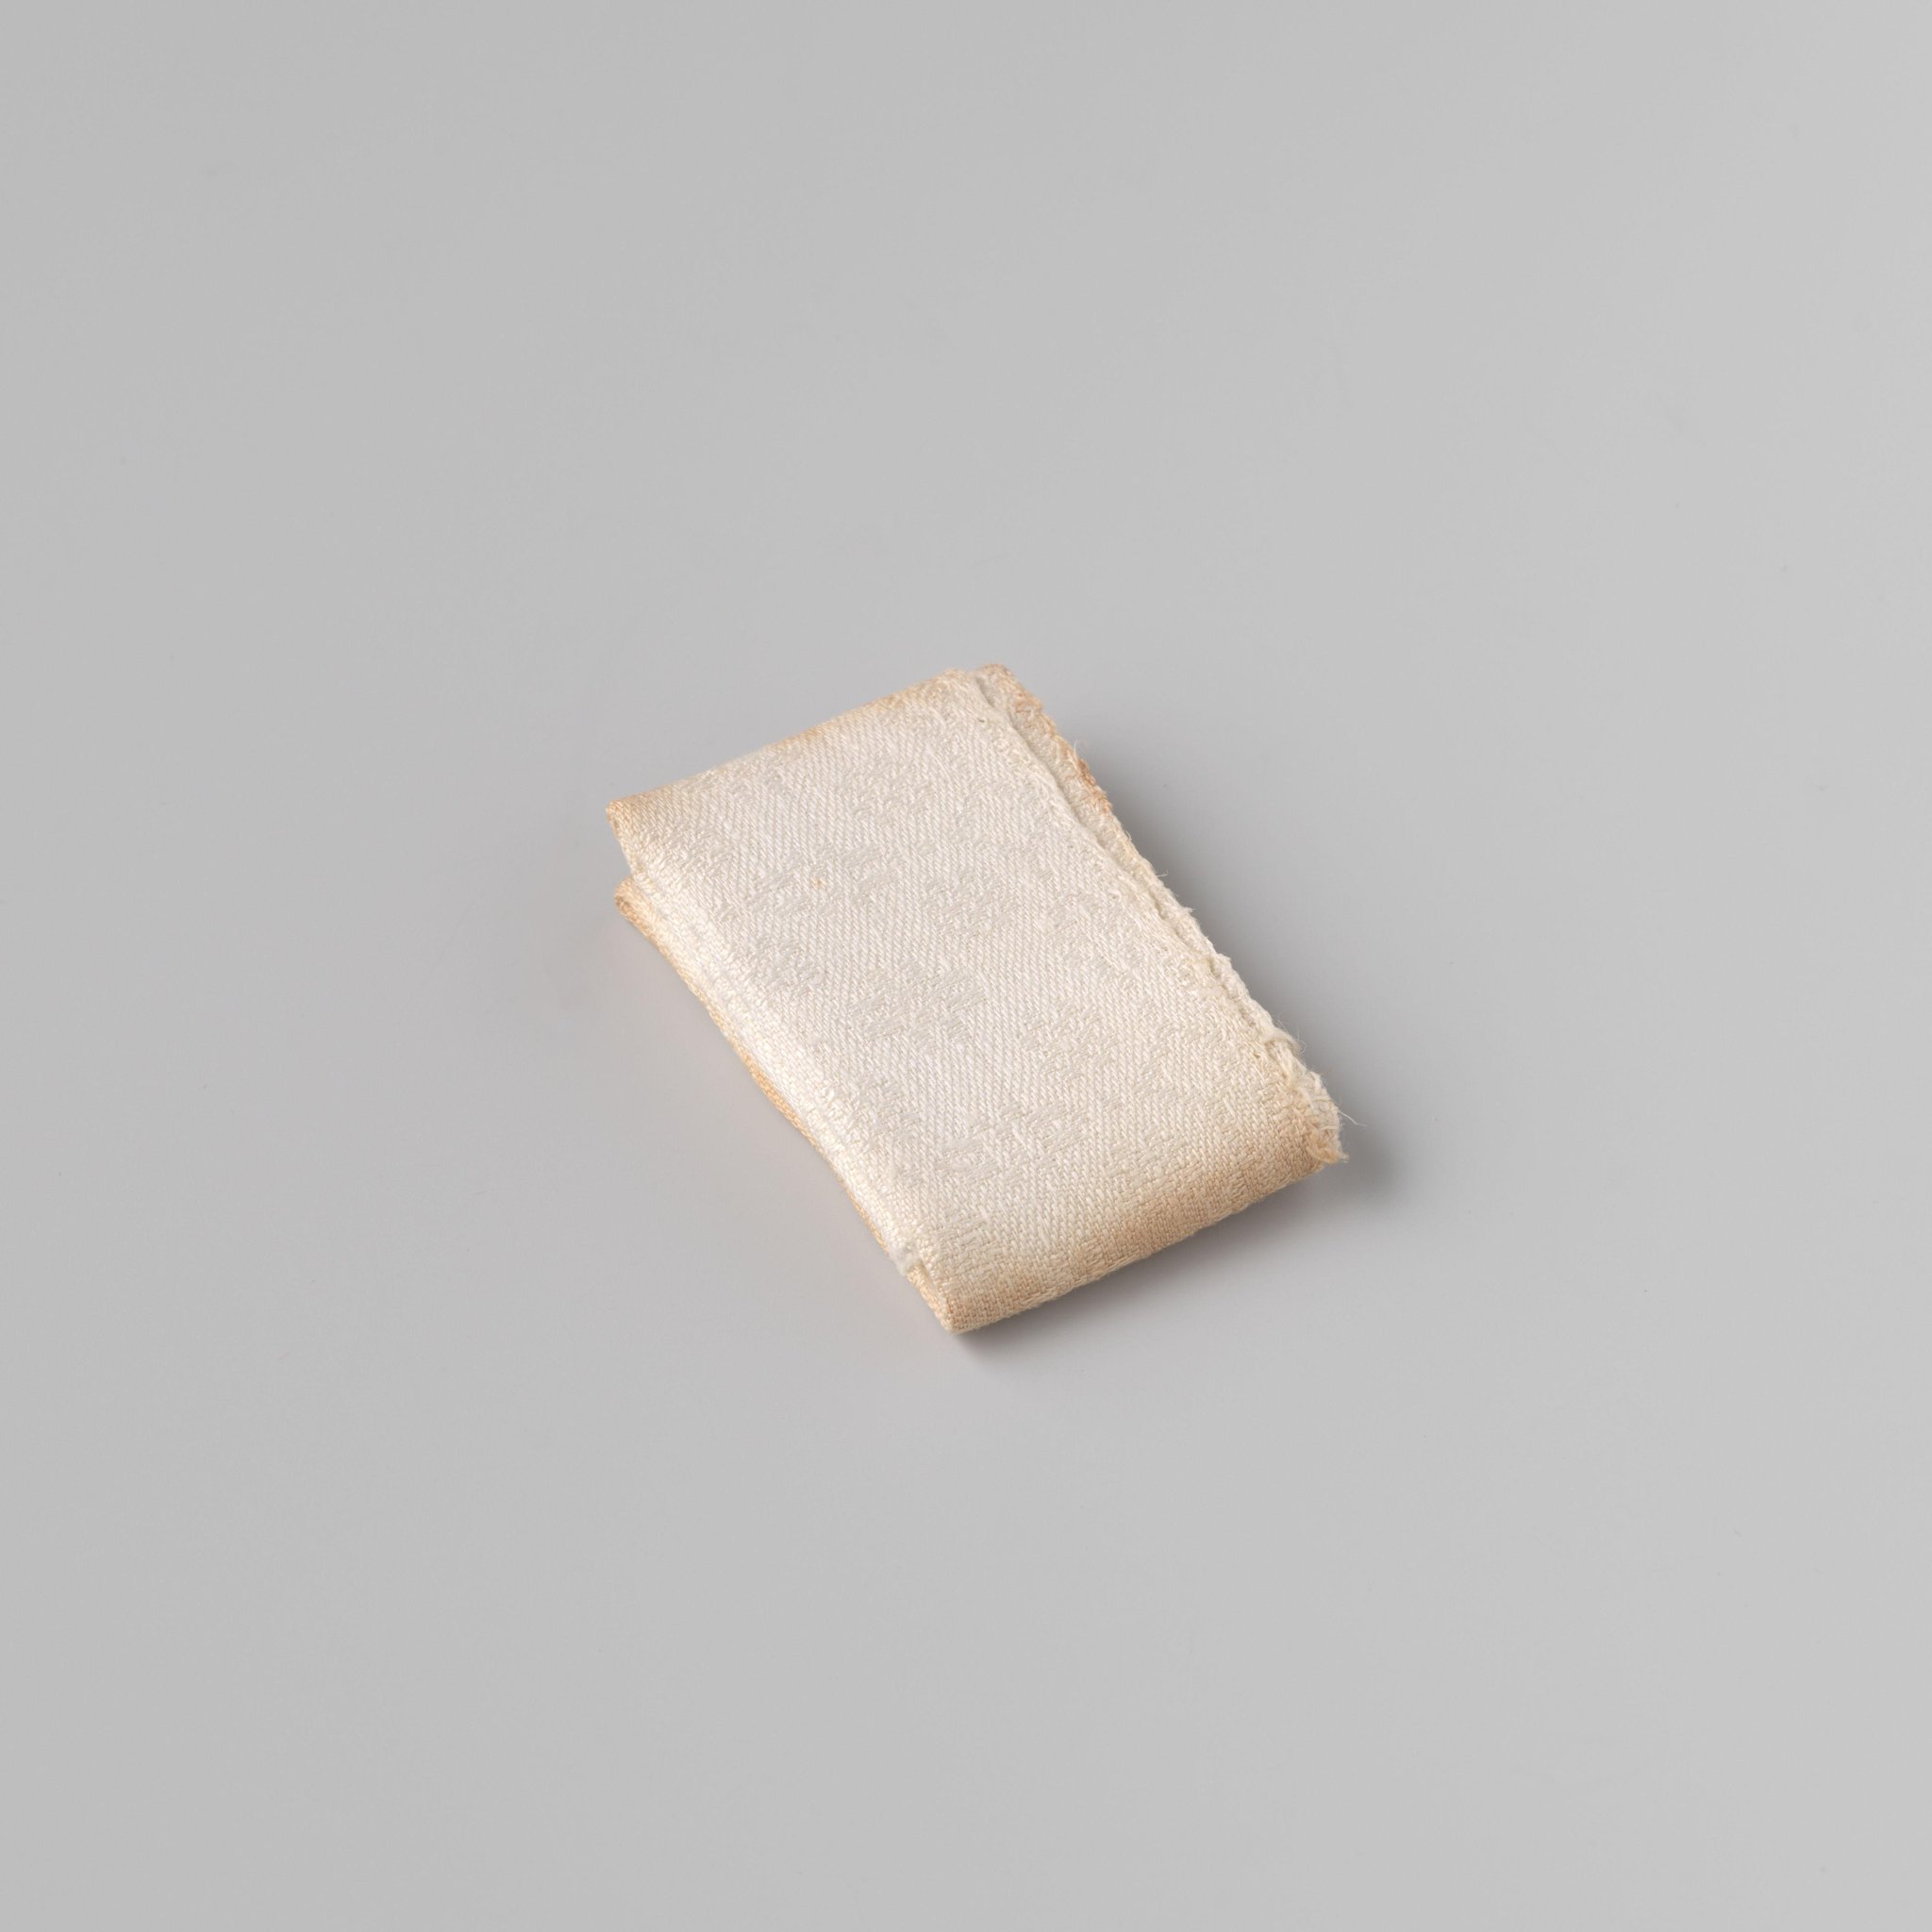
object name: miniature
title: Linnen servet van damastweefsel met pellenpatroon (motief I), geen zomen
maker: Anonymous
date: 1690-1710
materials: linen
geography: amsterdam